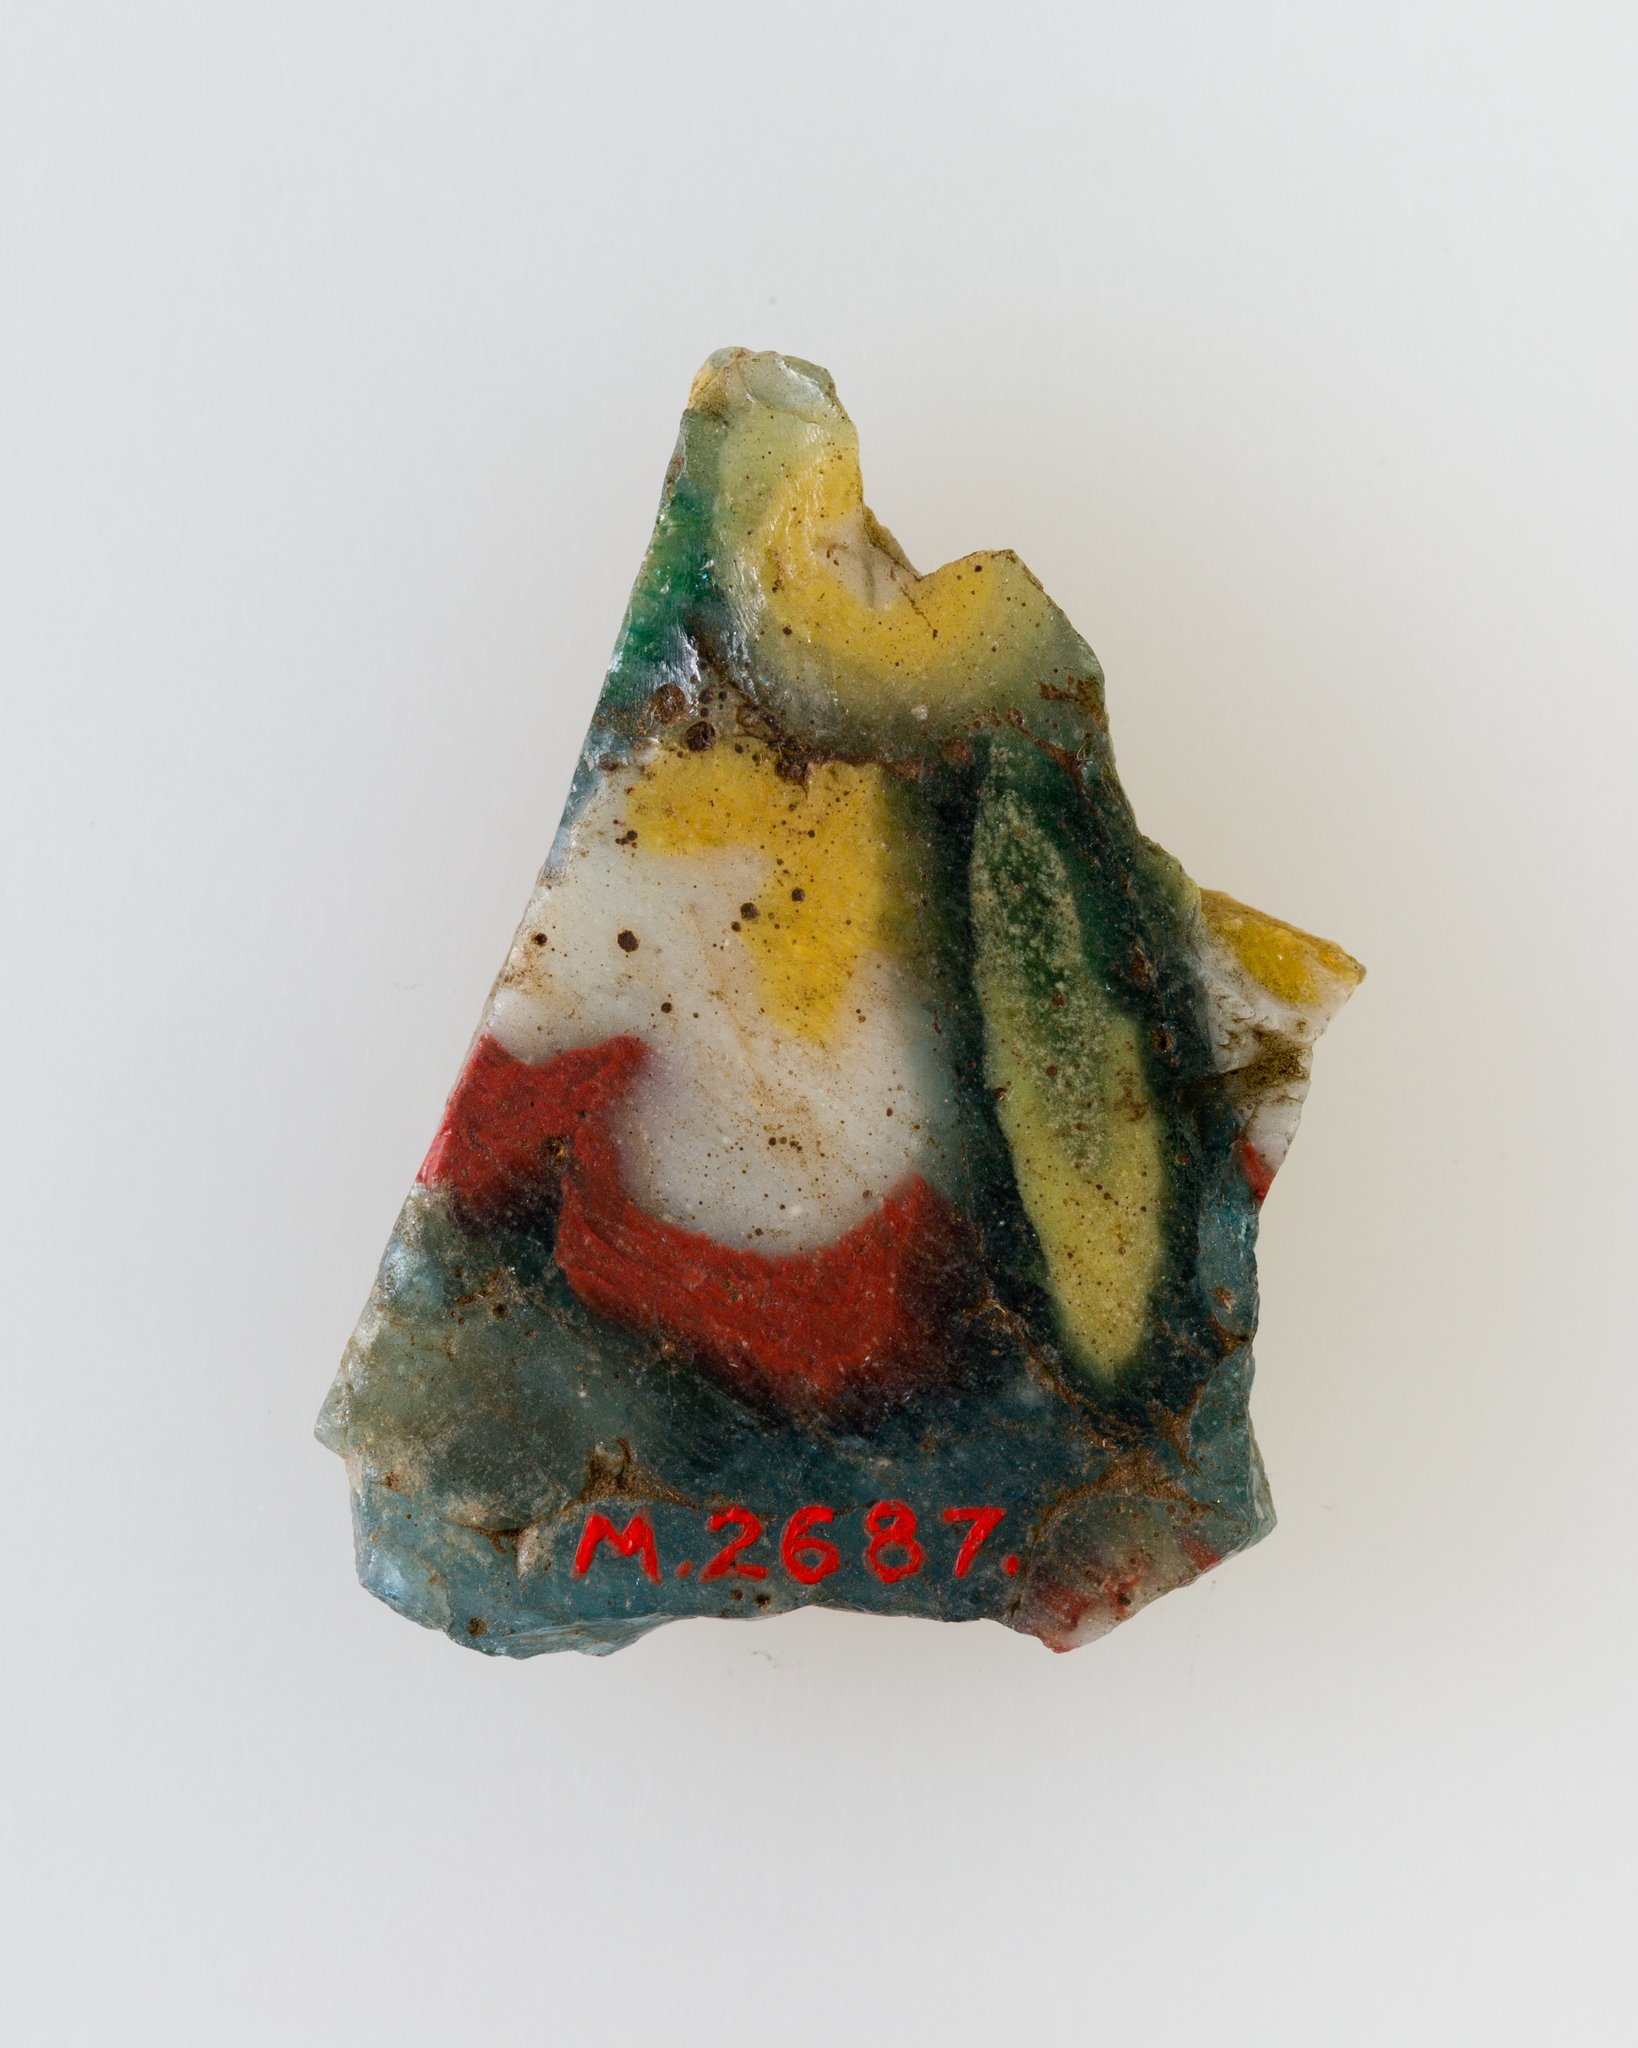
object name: plaque, floral, inlay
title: Floral plaque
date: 100 BCE-100 CE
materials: glass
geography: egypt